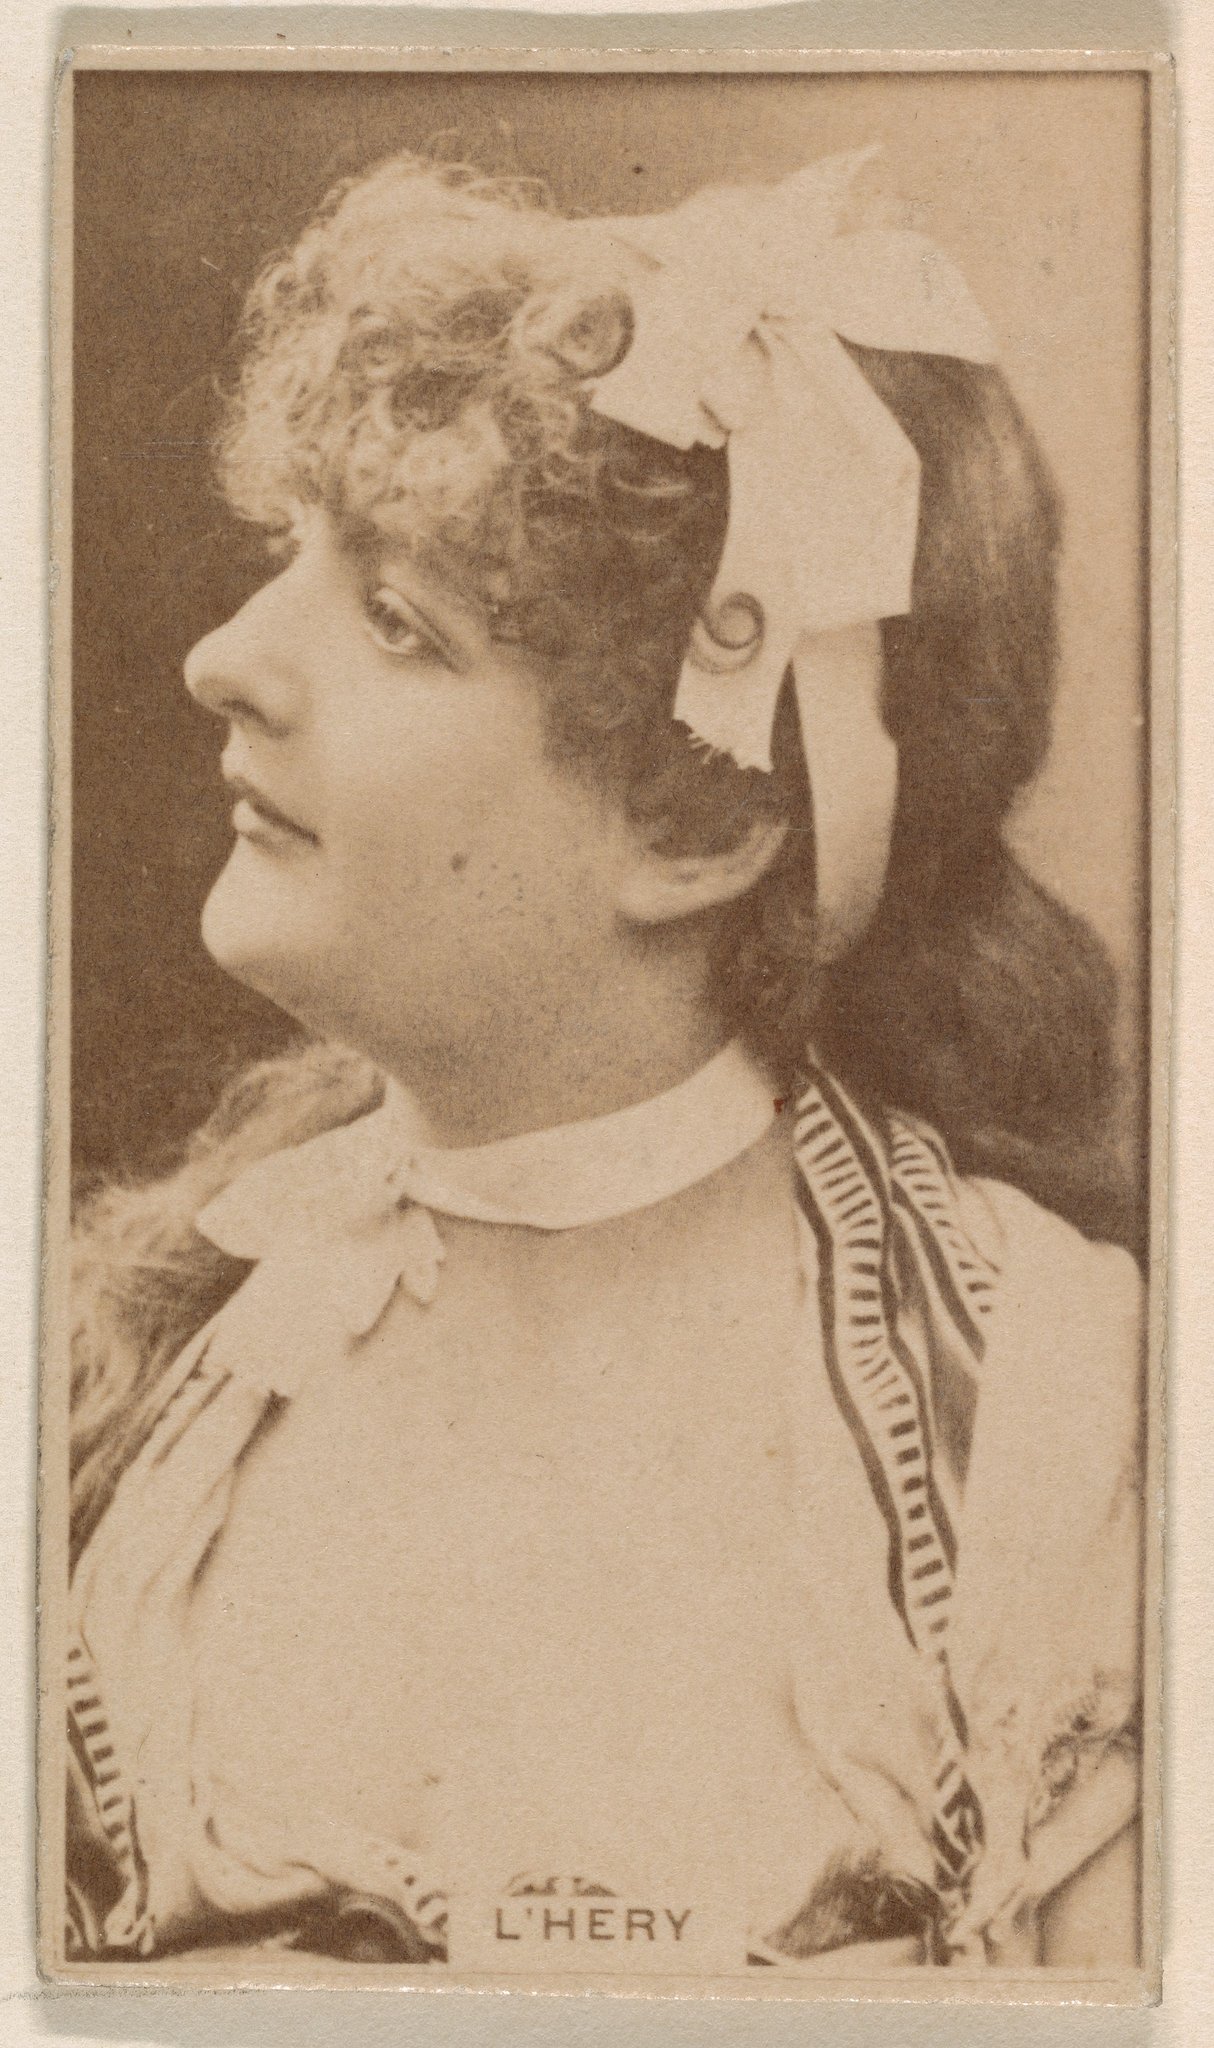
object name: photograph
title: Miss L'Hery, from the Actresses series (N245) issued by Kinney Brothers to promote Sweet Caporal Cigarettes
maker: kinney brothers tobacco company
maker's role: publisher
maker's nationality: american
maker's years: 1869-2011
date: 1890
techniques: albumen silver print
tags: women,actresses